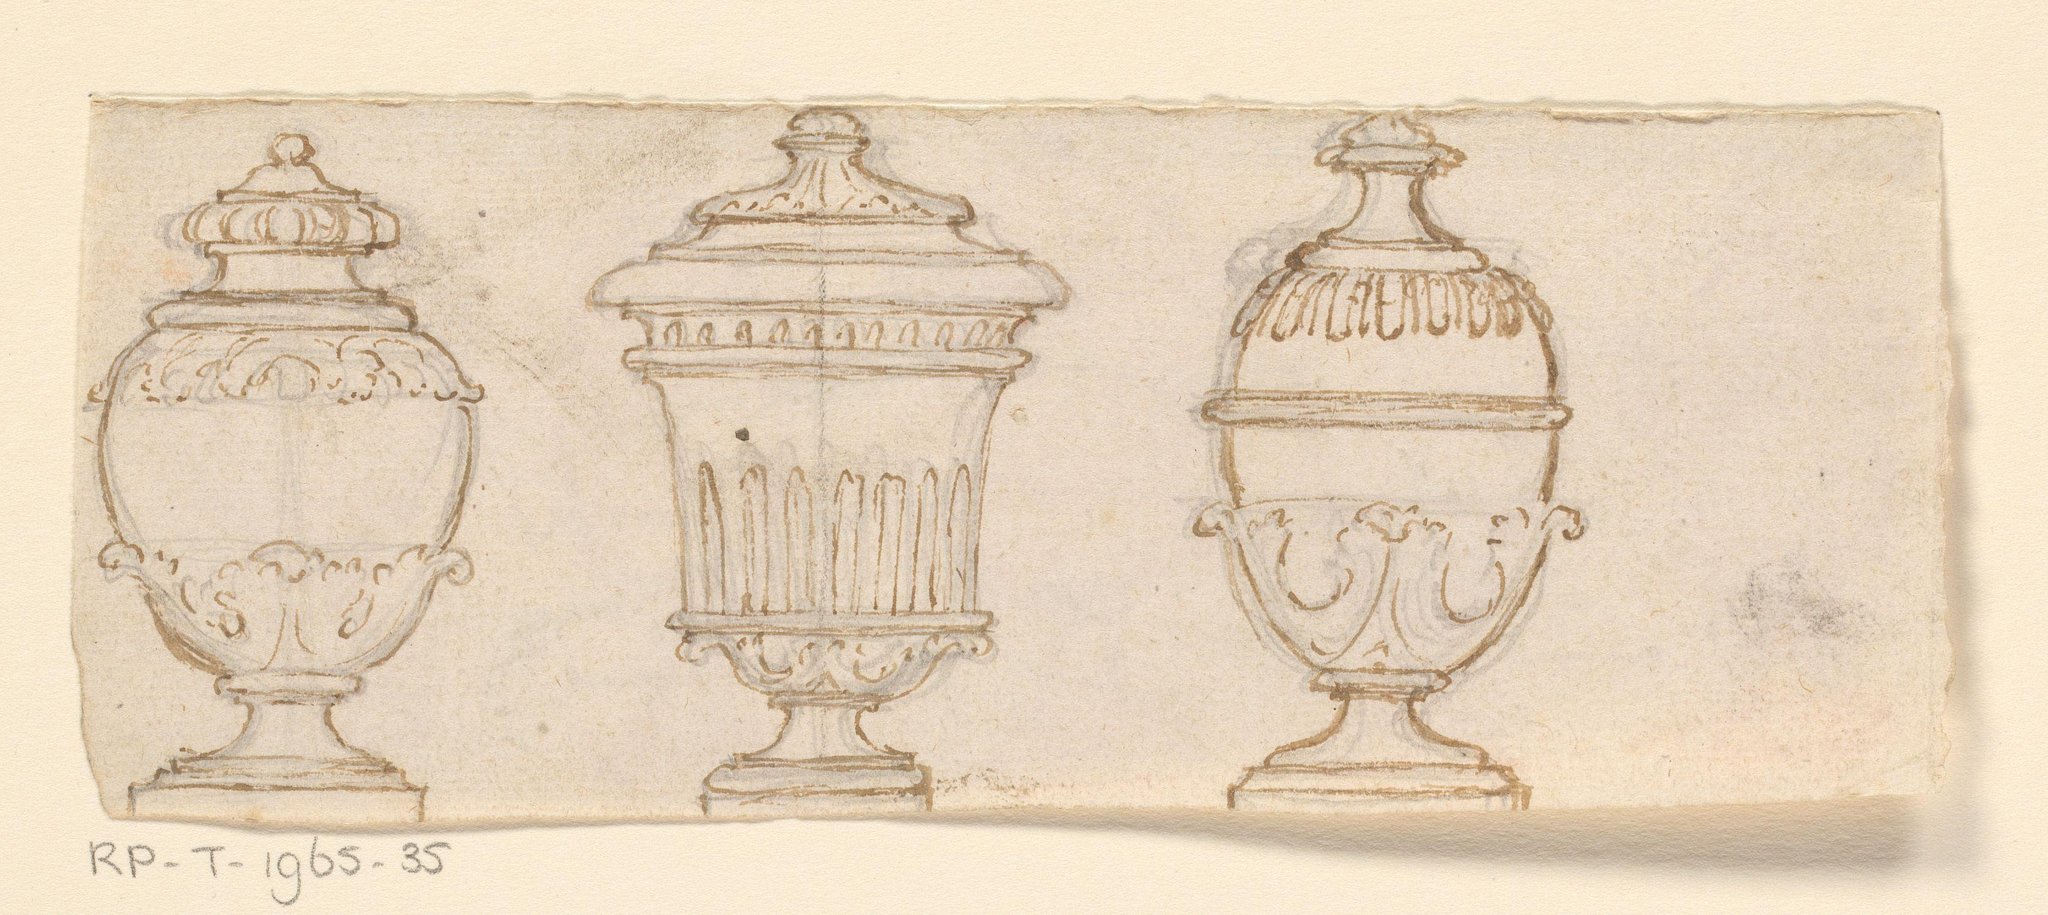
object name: ornamenttekening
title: Drie vazen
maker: Anonymous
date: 1650-1800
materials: ink, paper, pencil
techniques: pen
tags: vase ~ ornament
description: Drie geornamenteerde vazen met ribben en bladmotieven.